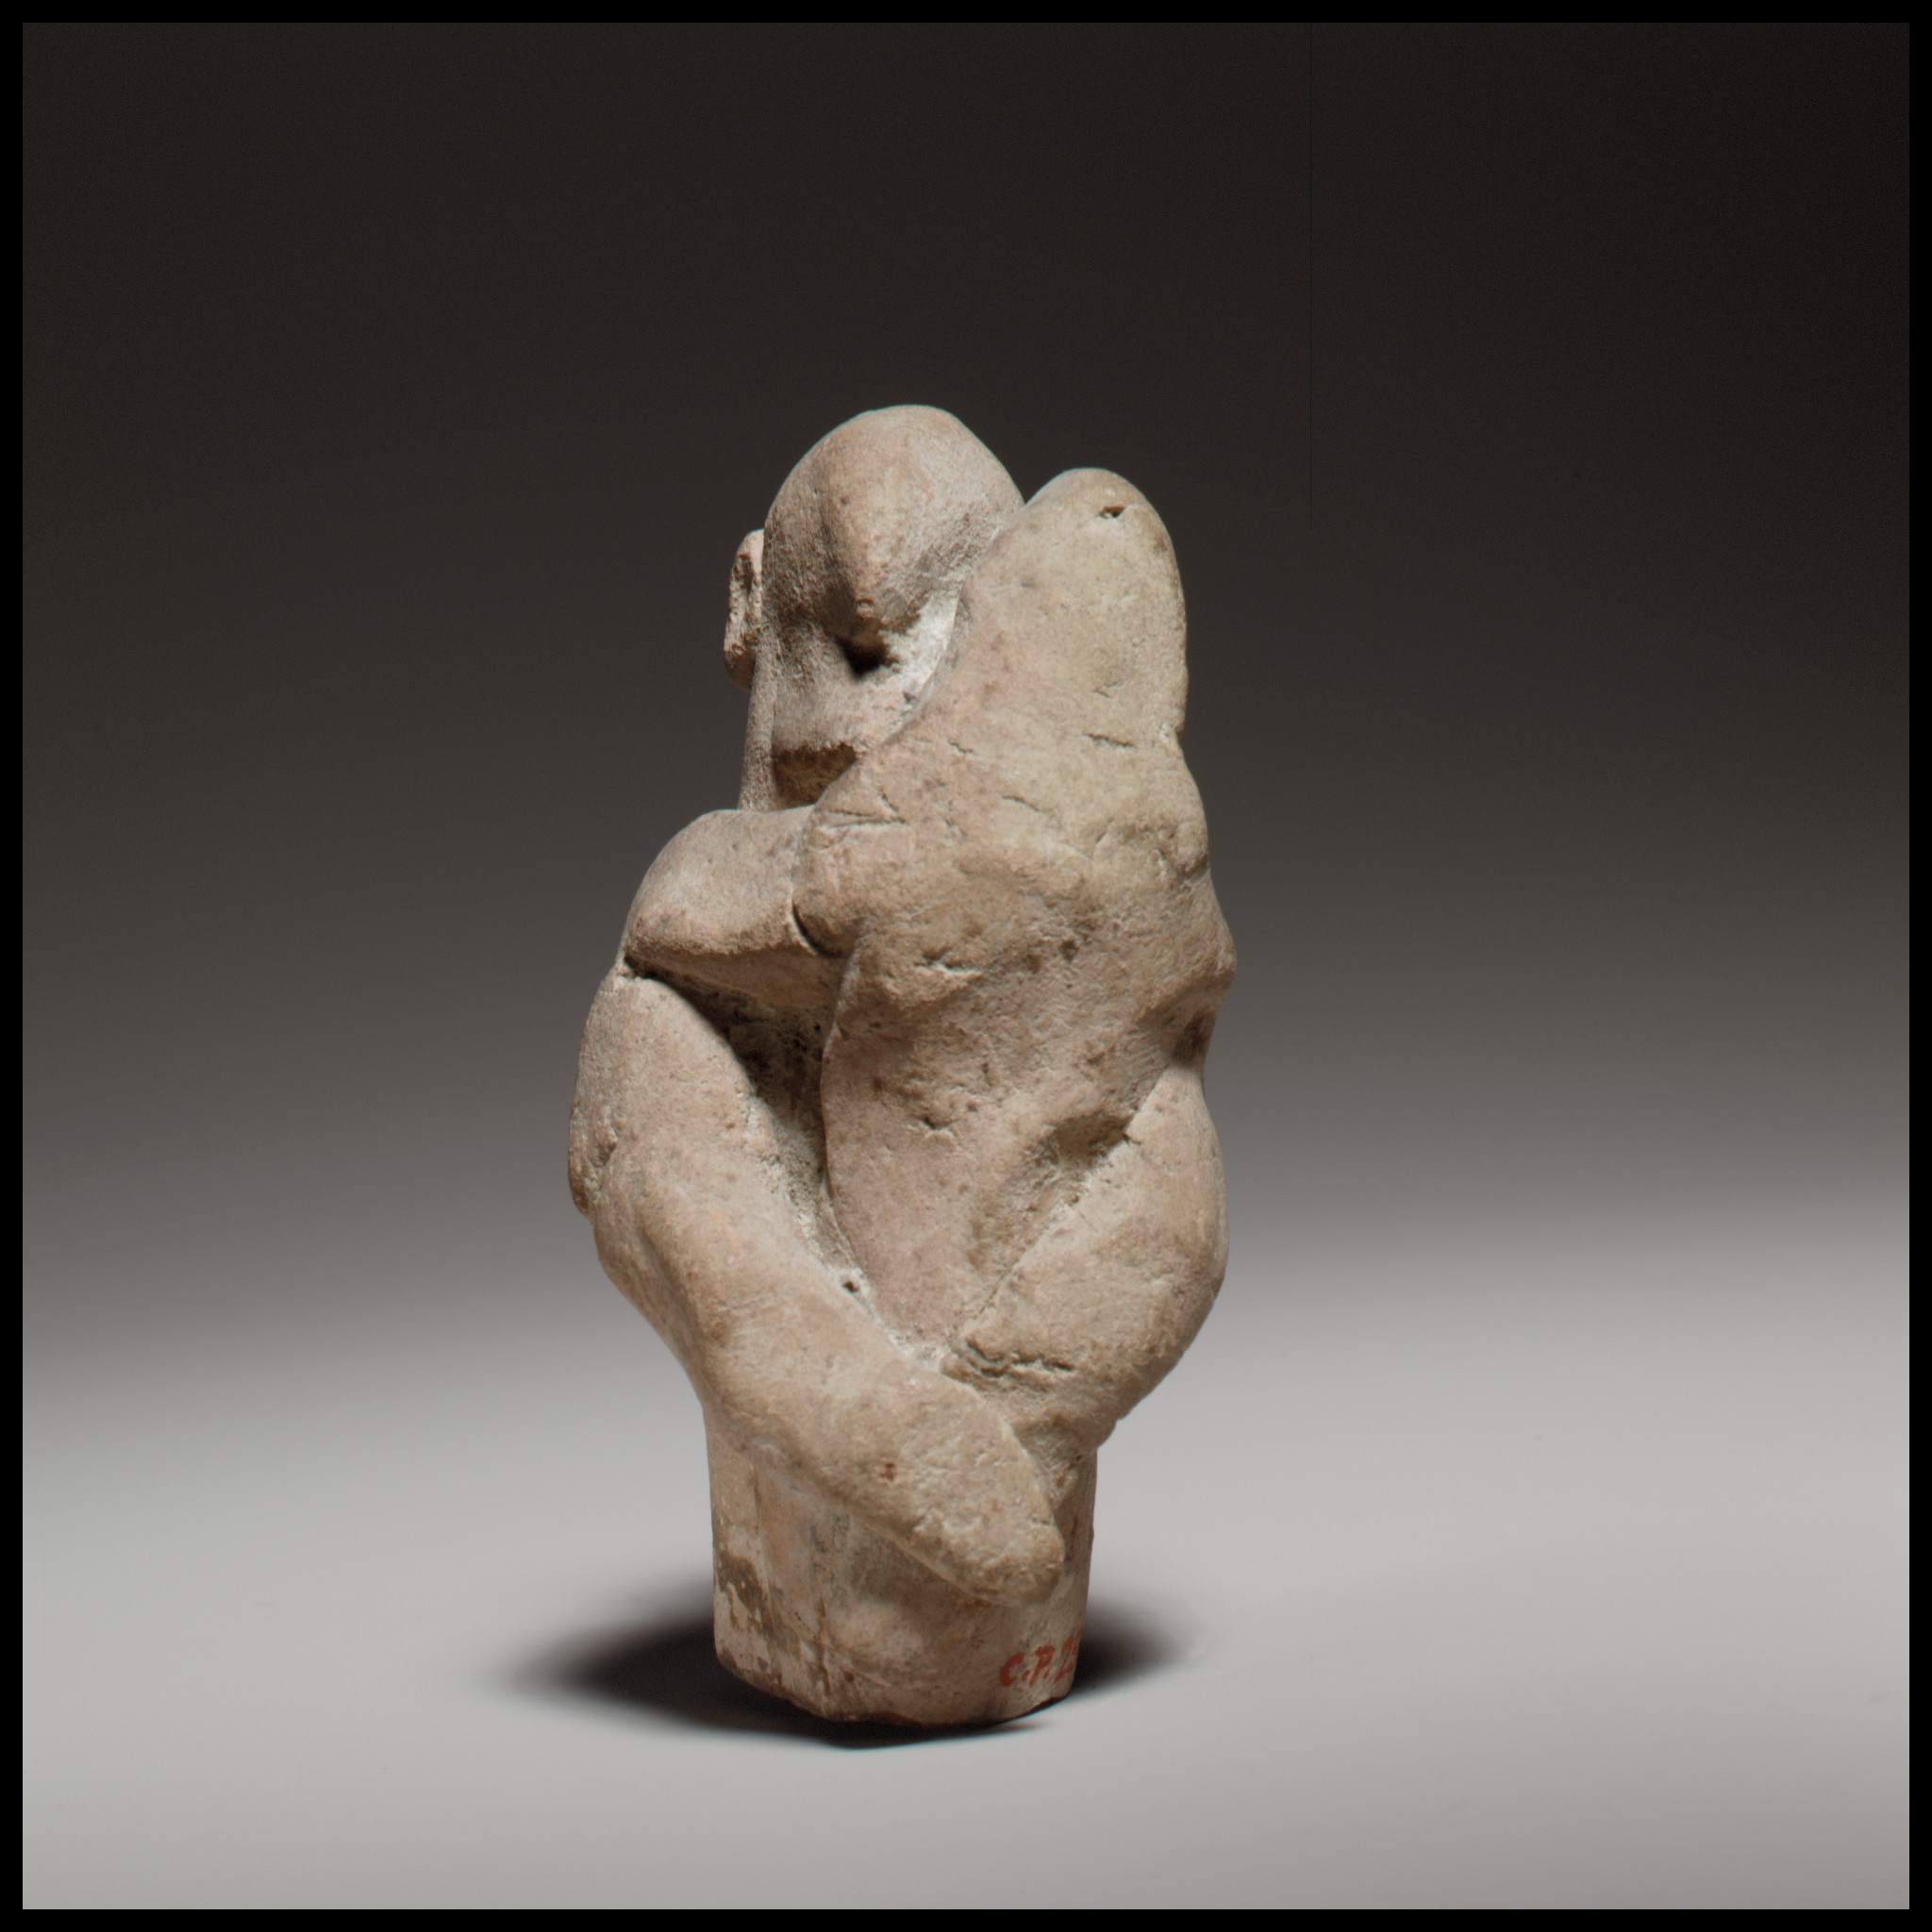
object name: statuette of a woman in childbirth, group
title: Two figures in a scene of childbirth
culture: cypriot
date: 600-480 BCE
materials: terracotta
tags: men,women